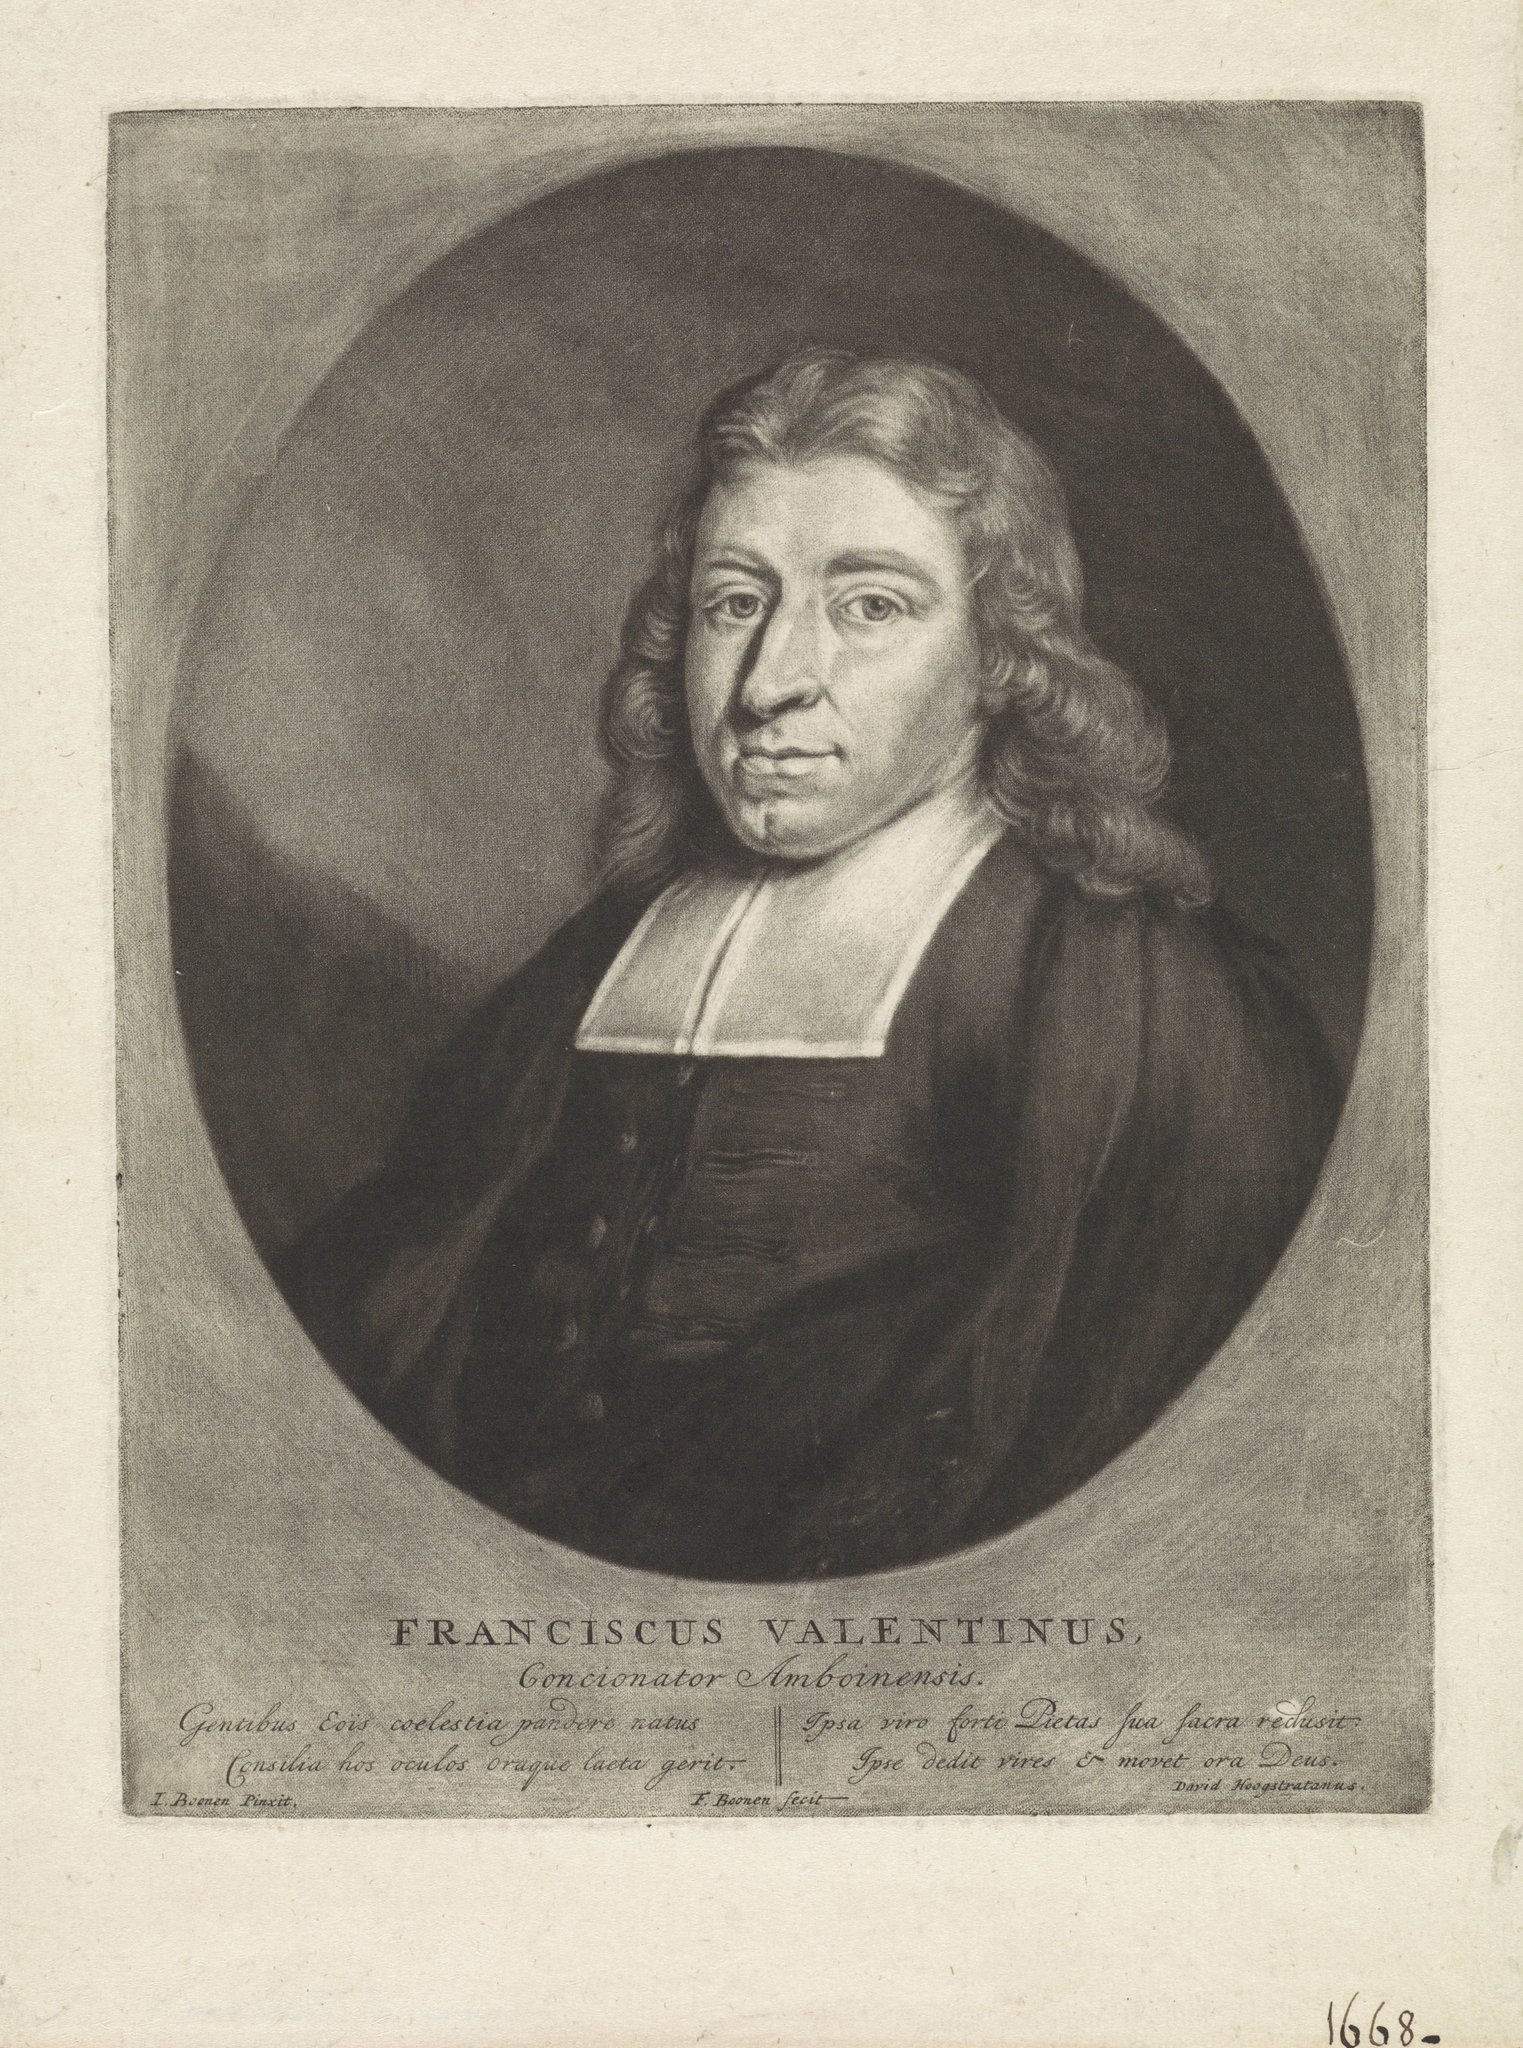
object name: print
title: Portret van de historicus en dominee François Valentijn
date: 1708-1800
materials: paper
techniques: engraving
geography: middelburg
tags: dordrecht, the hague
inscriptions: collector's mark: Lugt 2228